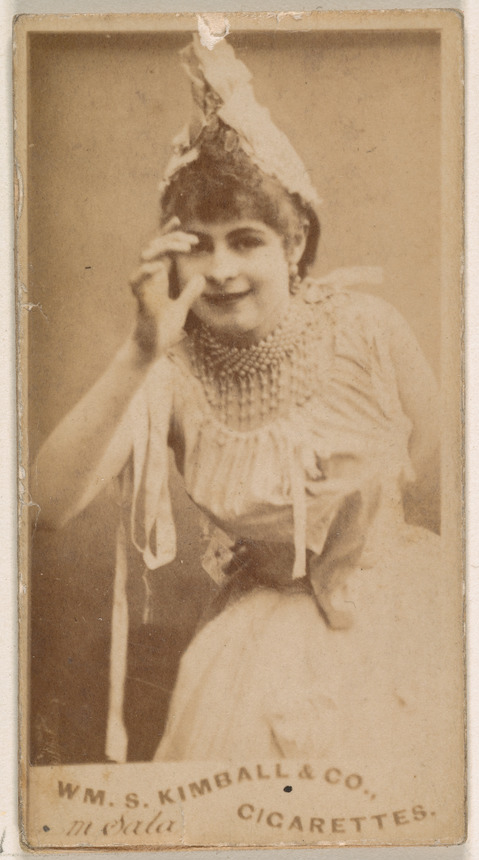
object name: photograph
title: Miss Sala, from the Actresses series (N203) issued by Wm. S. Kimball & Co.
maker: william s. kimball & company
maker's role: publisher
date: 1889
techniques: color lithograph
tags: portraits,women,actresses